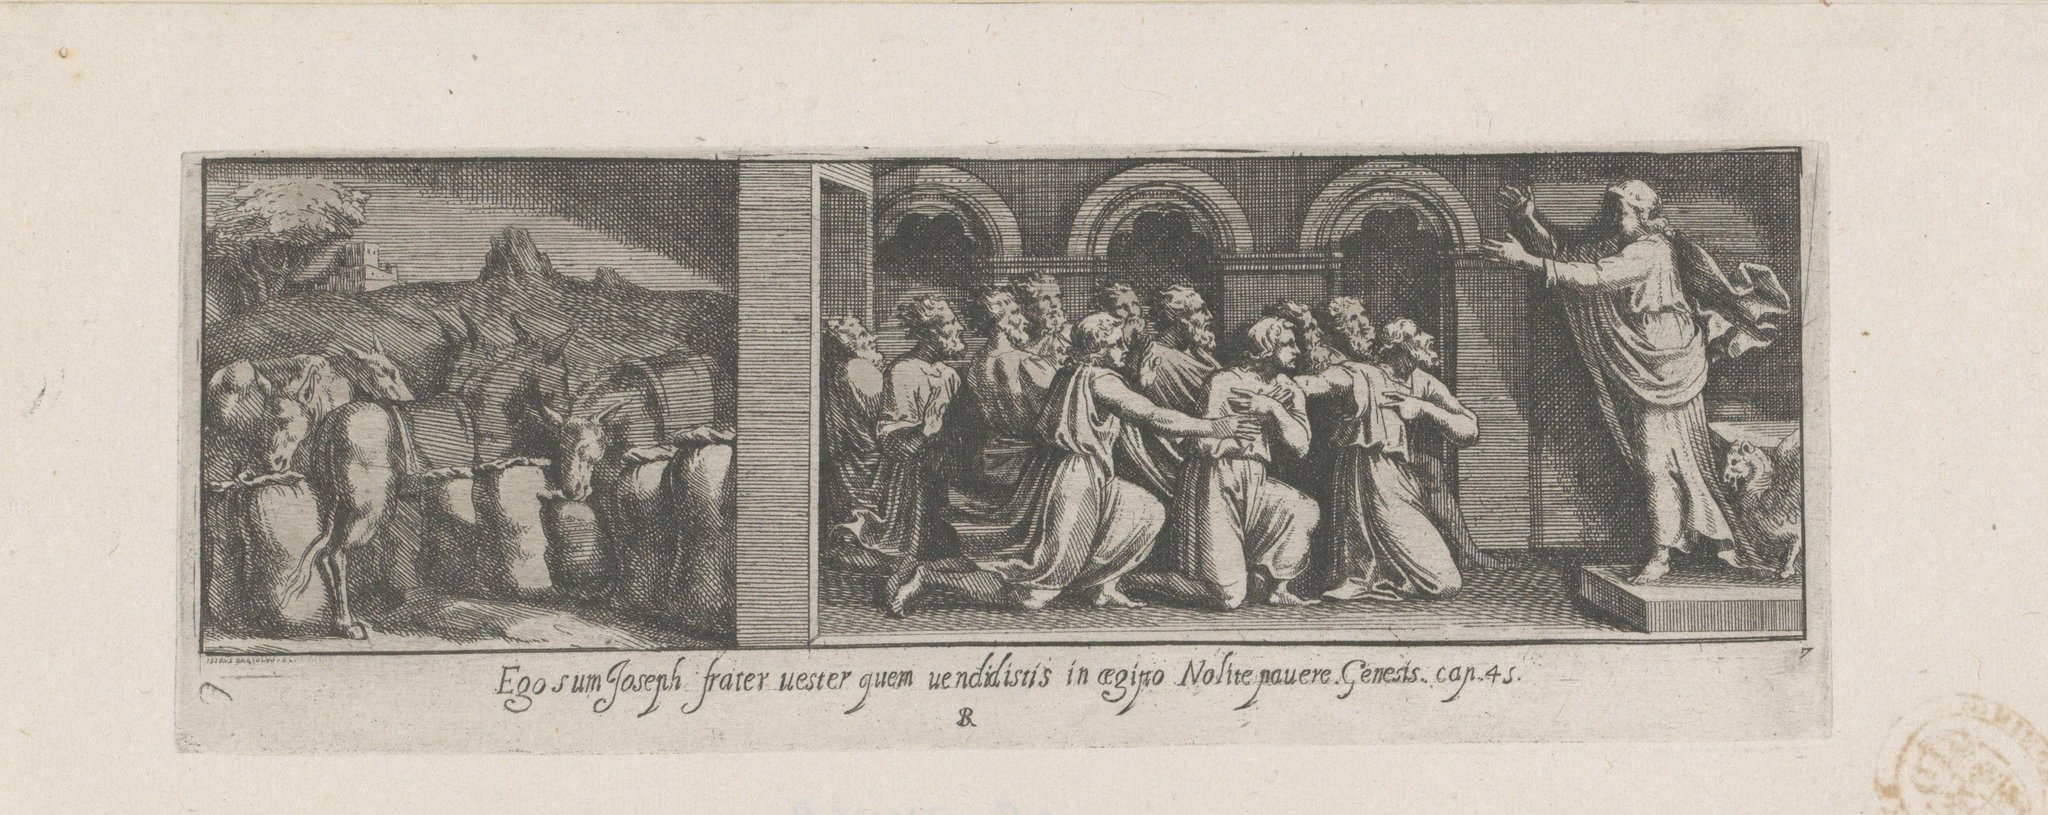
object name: print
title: Verloren gegane schilderderingen in de Vaticaanse Loggia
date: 1645-1700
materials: paper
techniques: engraving, etching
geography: vatican city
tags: admitted in joseph's presence, the brothers bow down before him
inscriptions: collector's mark: Lugt 240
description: Jozef staat op een verhoging en spreekt zijn broers toe die geknield voor hem zitten. Buiten staan ezels en zakken graan. Titel en verwijzing naar Bijbeltekst in ondermarge.